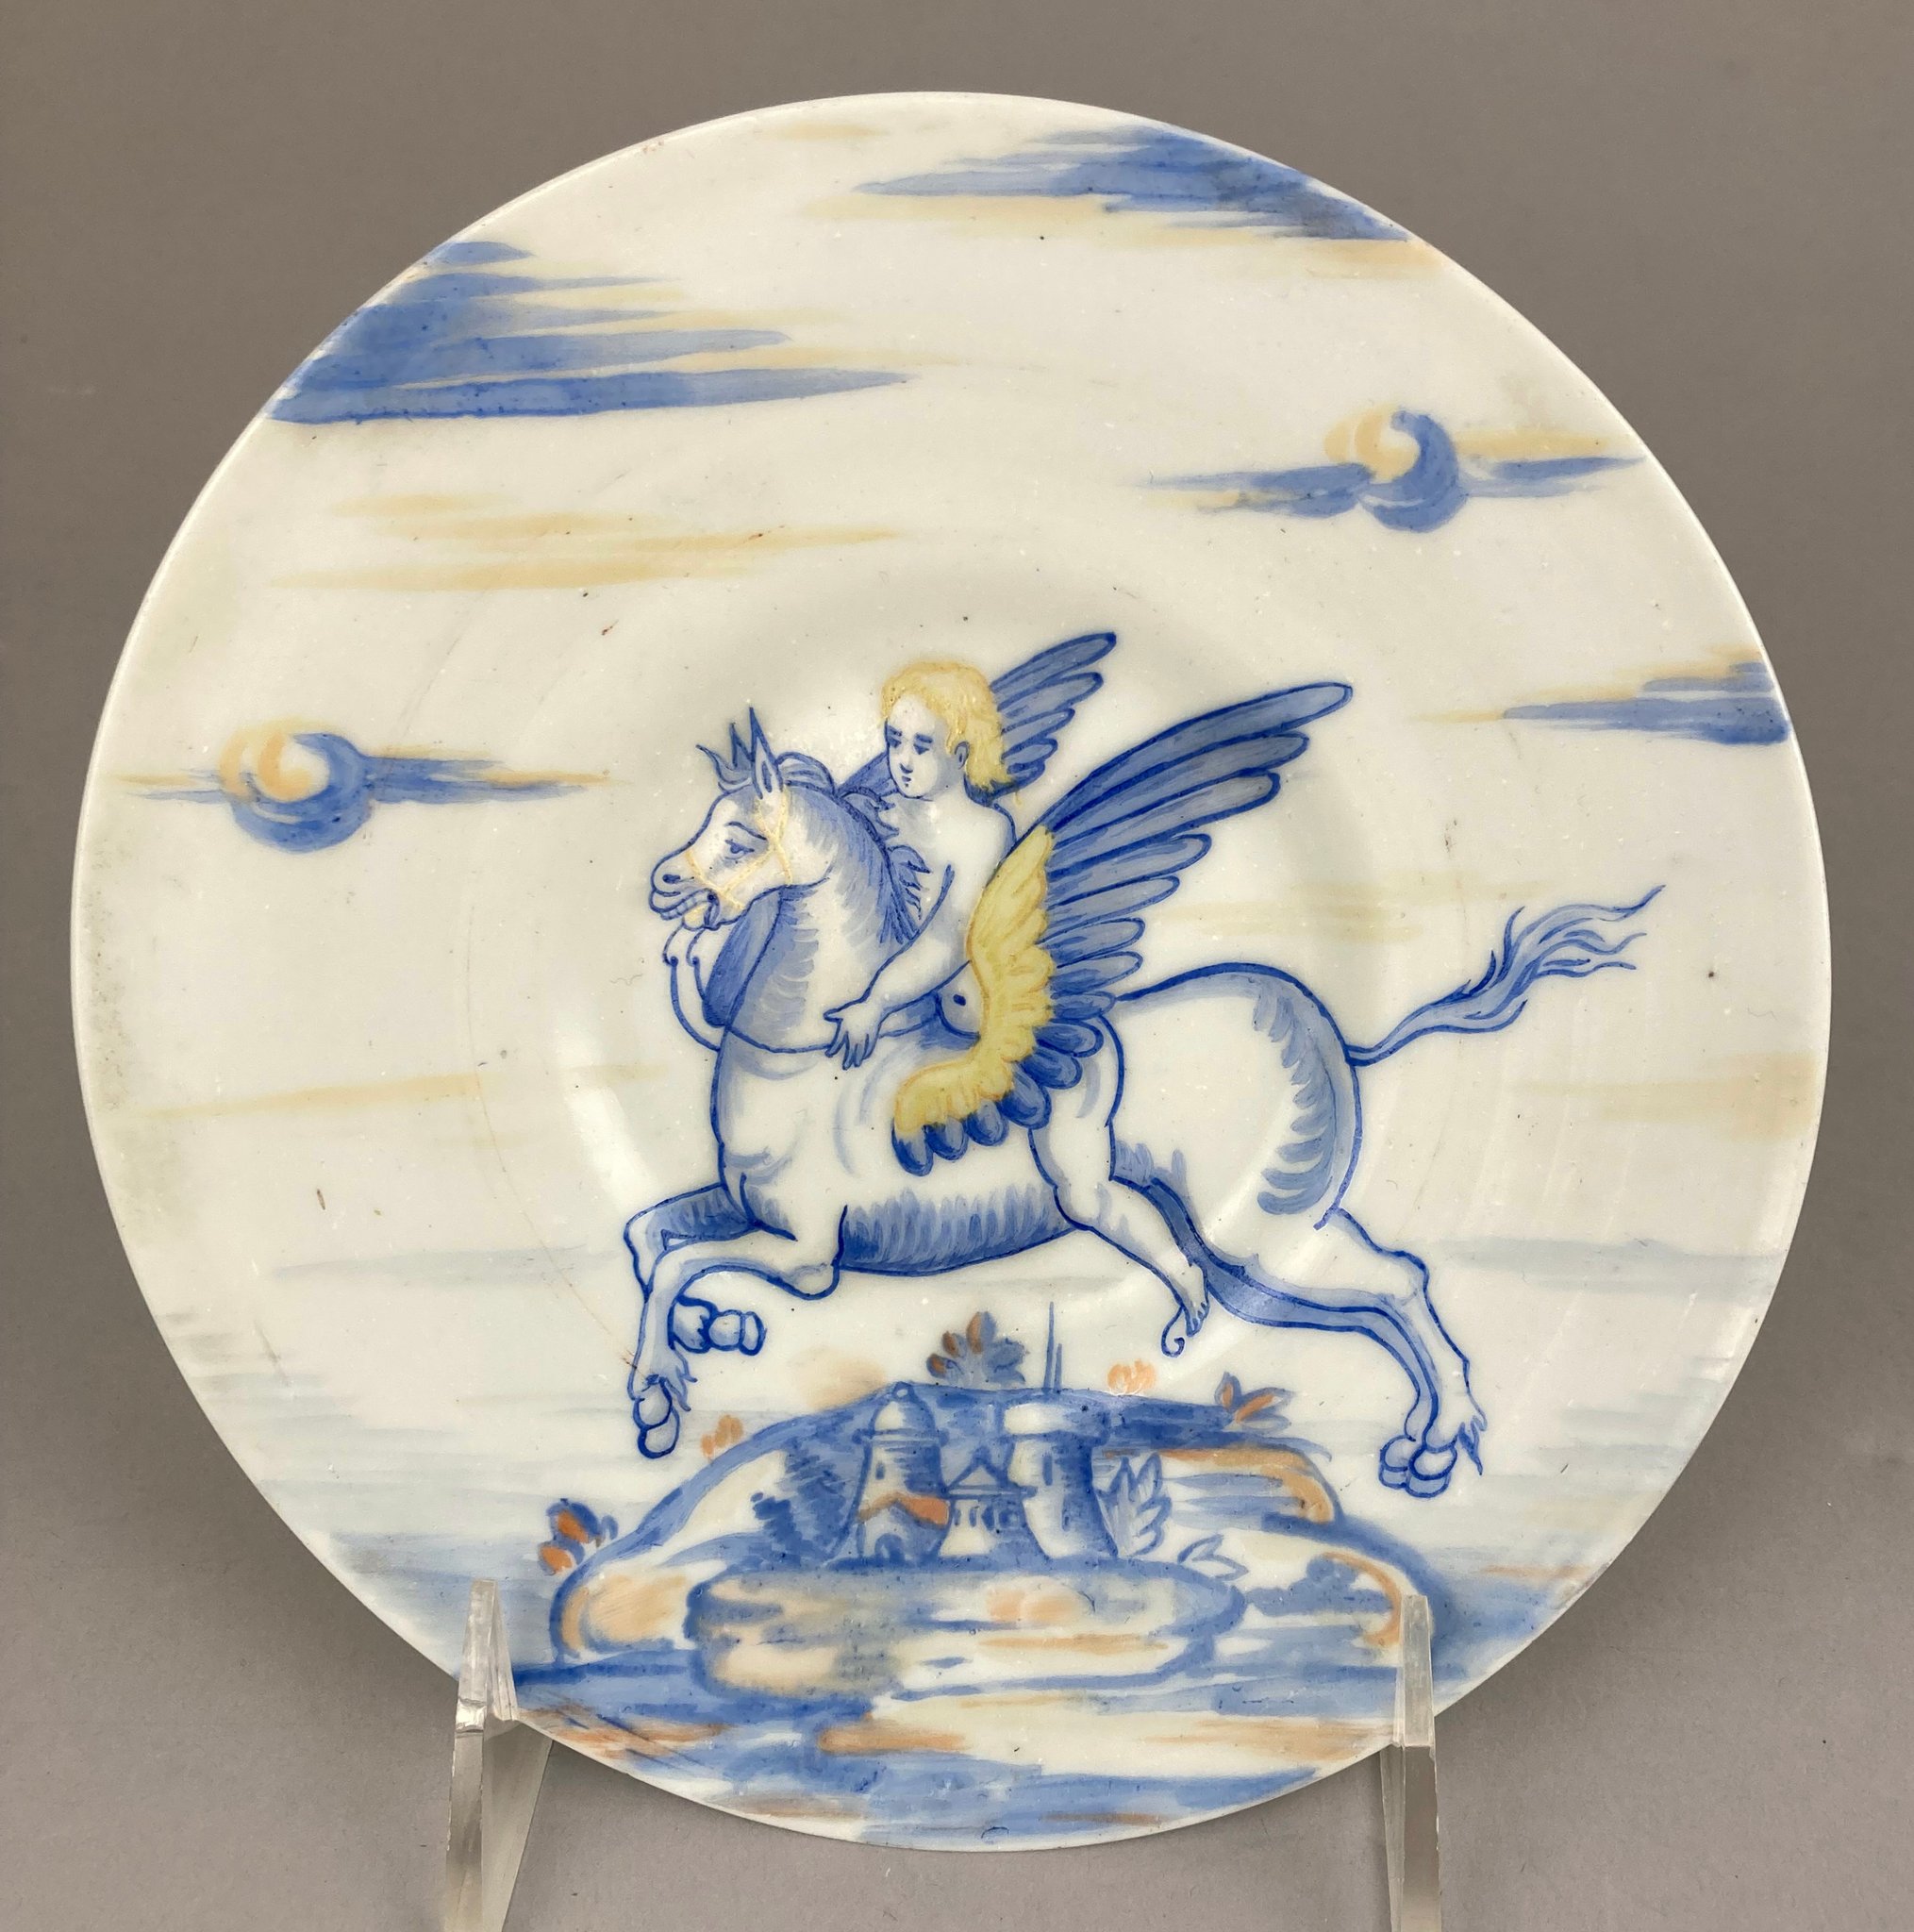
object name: plate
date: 1501-1600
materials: glass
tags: pegasus